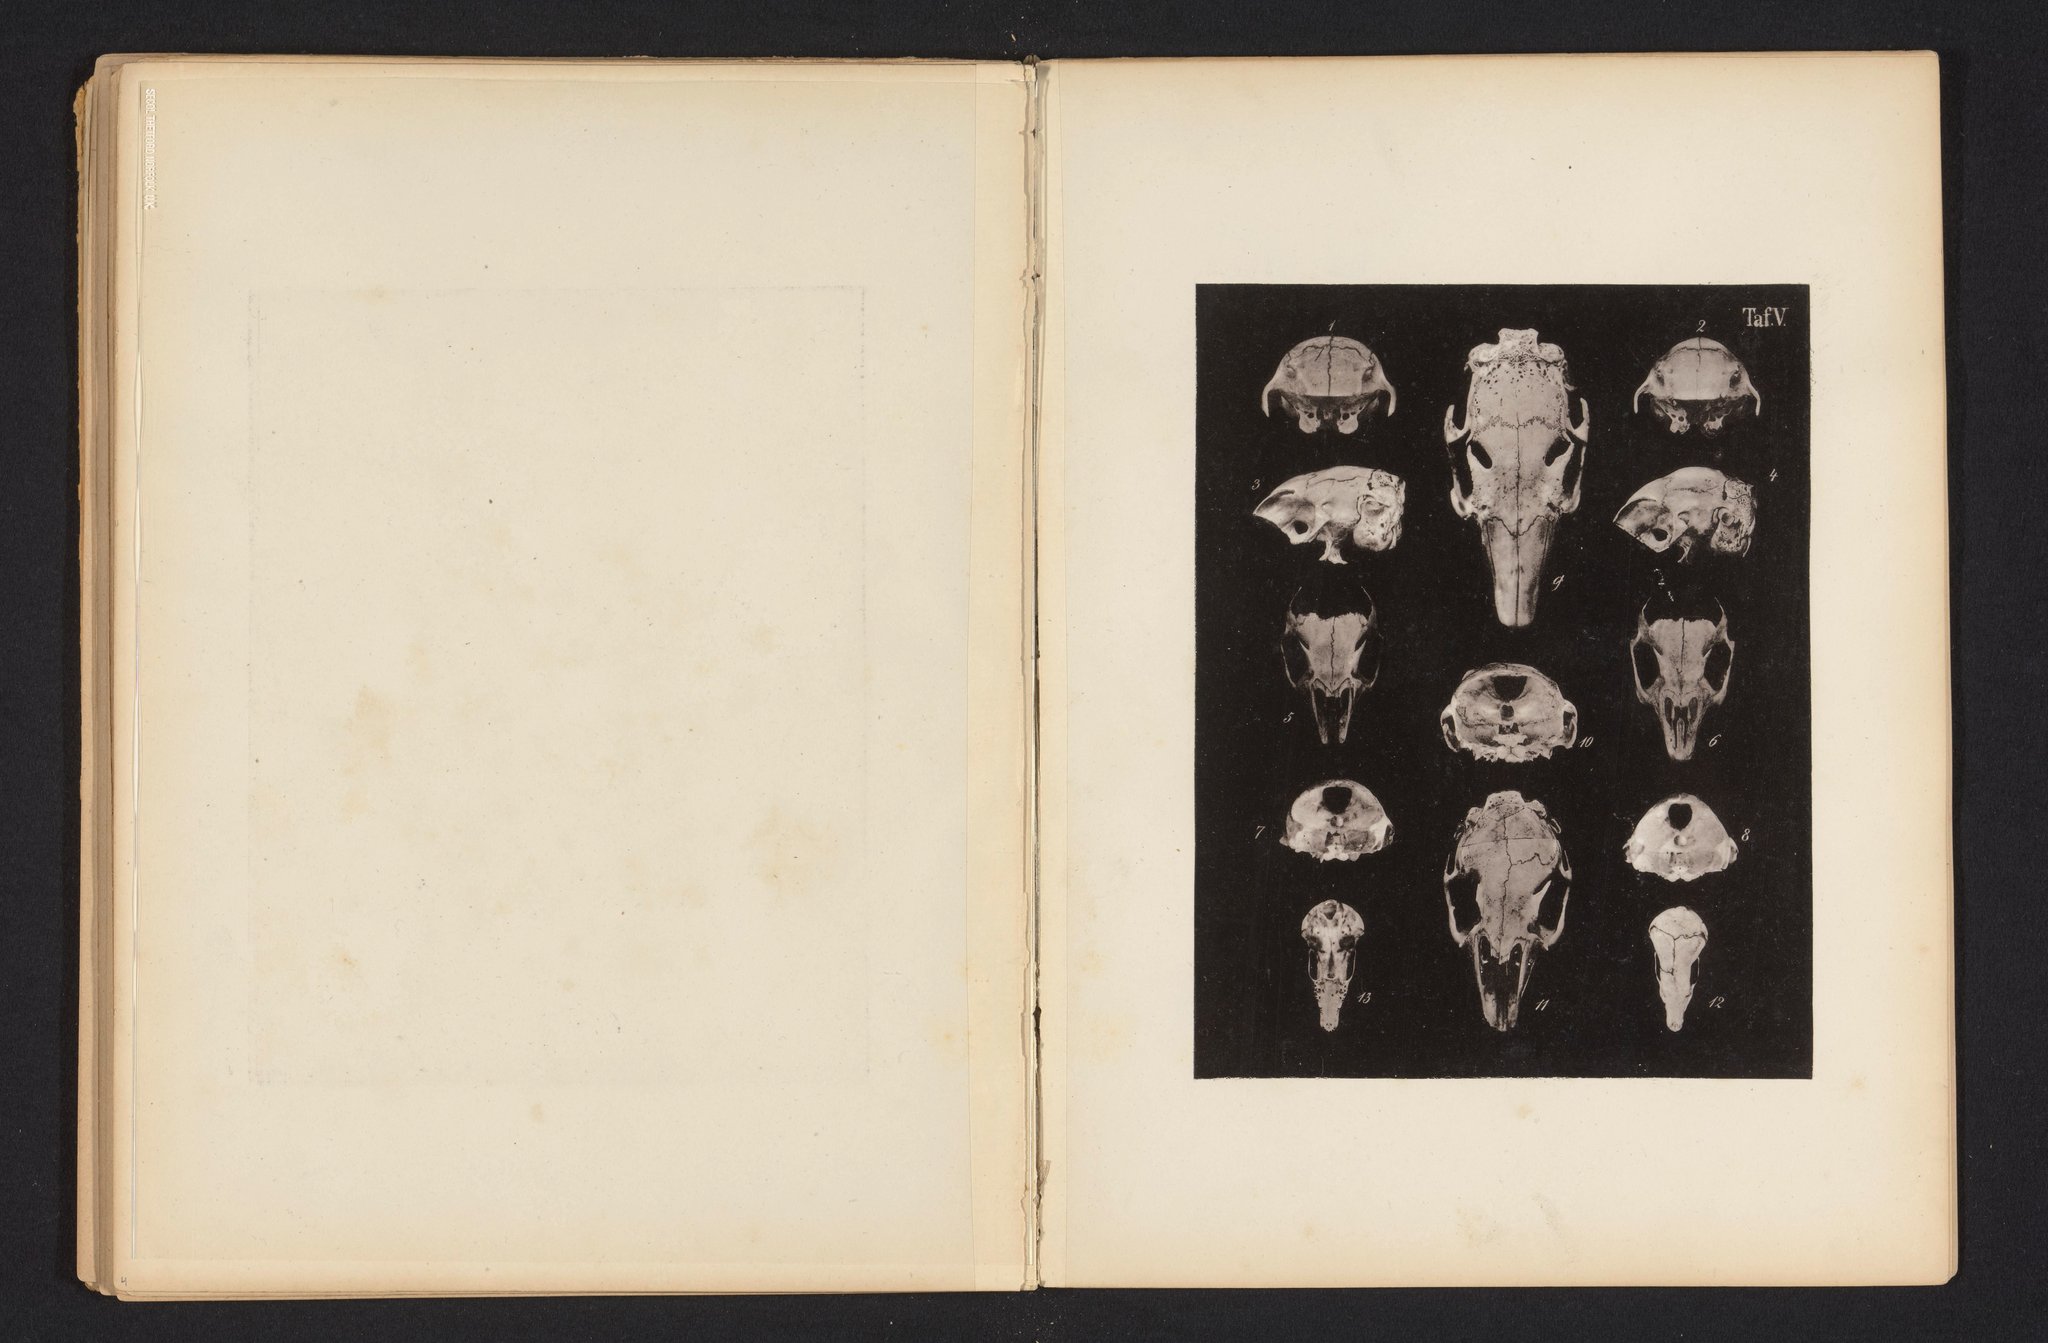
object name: photomechanical print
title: Dertien aangezichten van een konijnenschedel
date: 1864-1874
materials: paper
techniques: photograph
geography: germany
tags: (human) skull, rodents: rabbit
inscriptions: number: ‘Taf. V. 1 2 3 4 5 6 7 8 9 10 11 12 13’